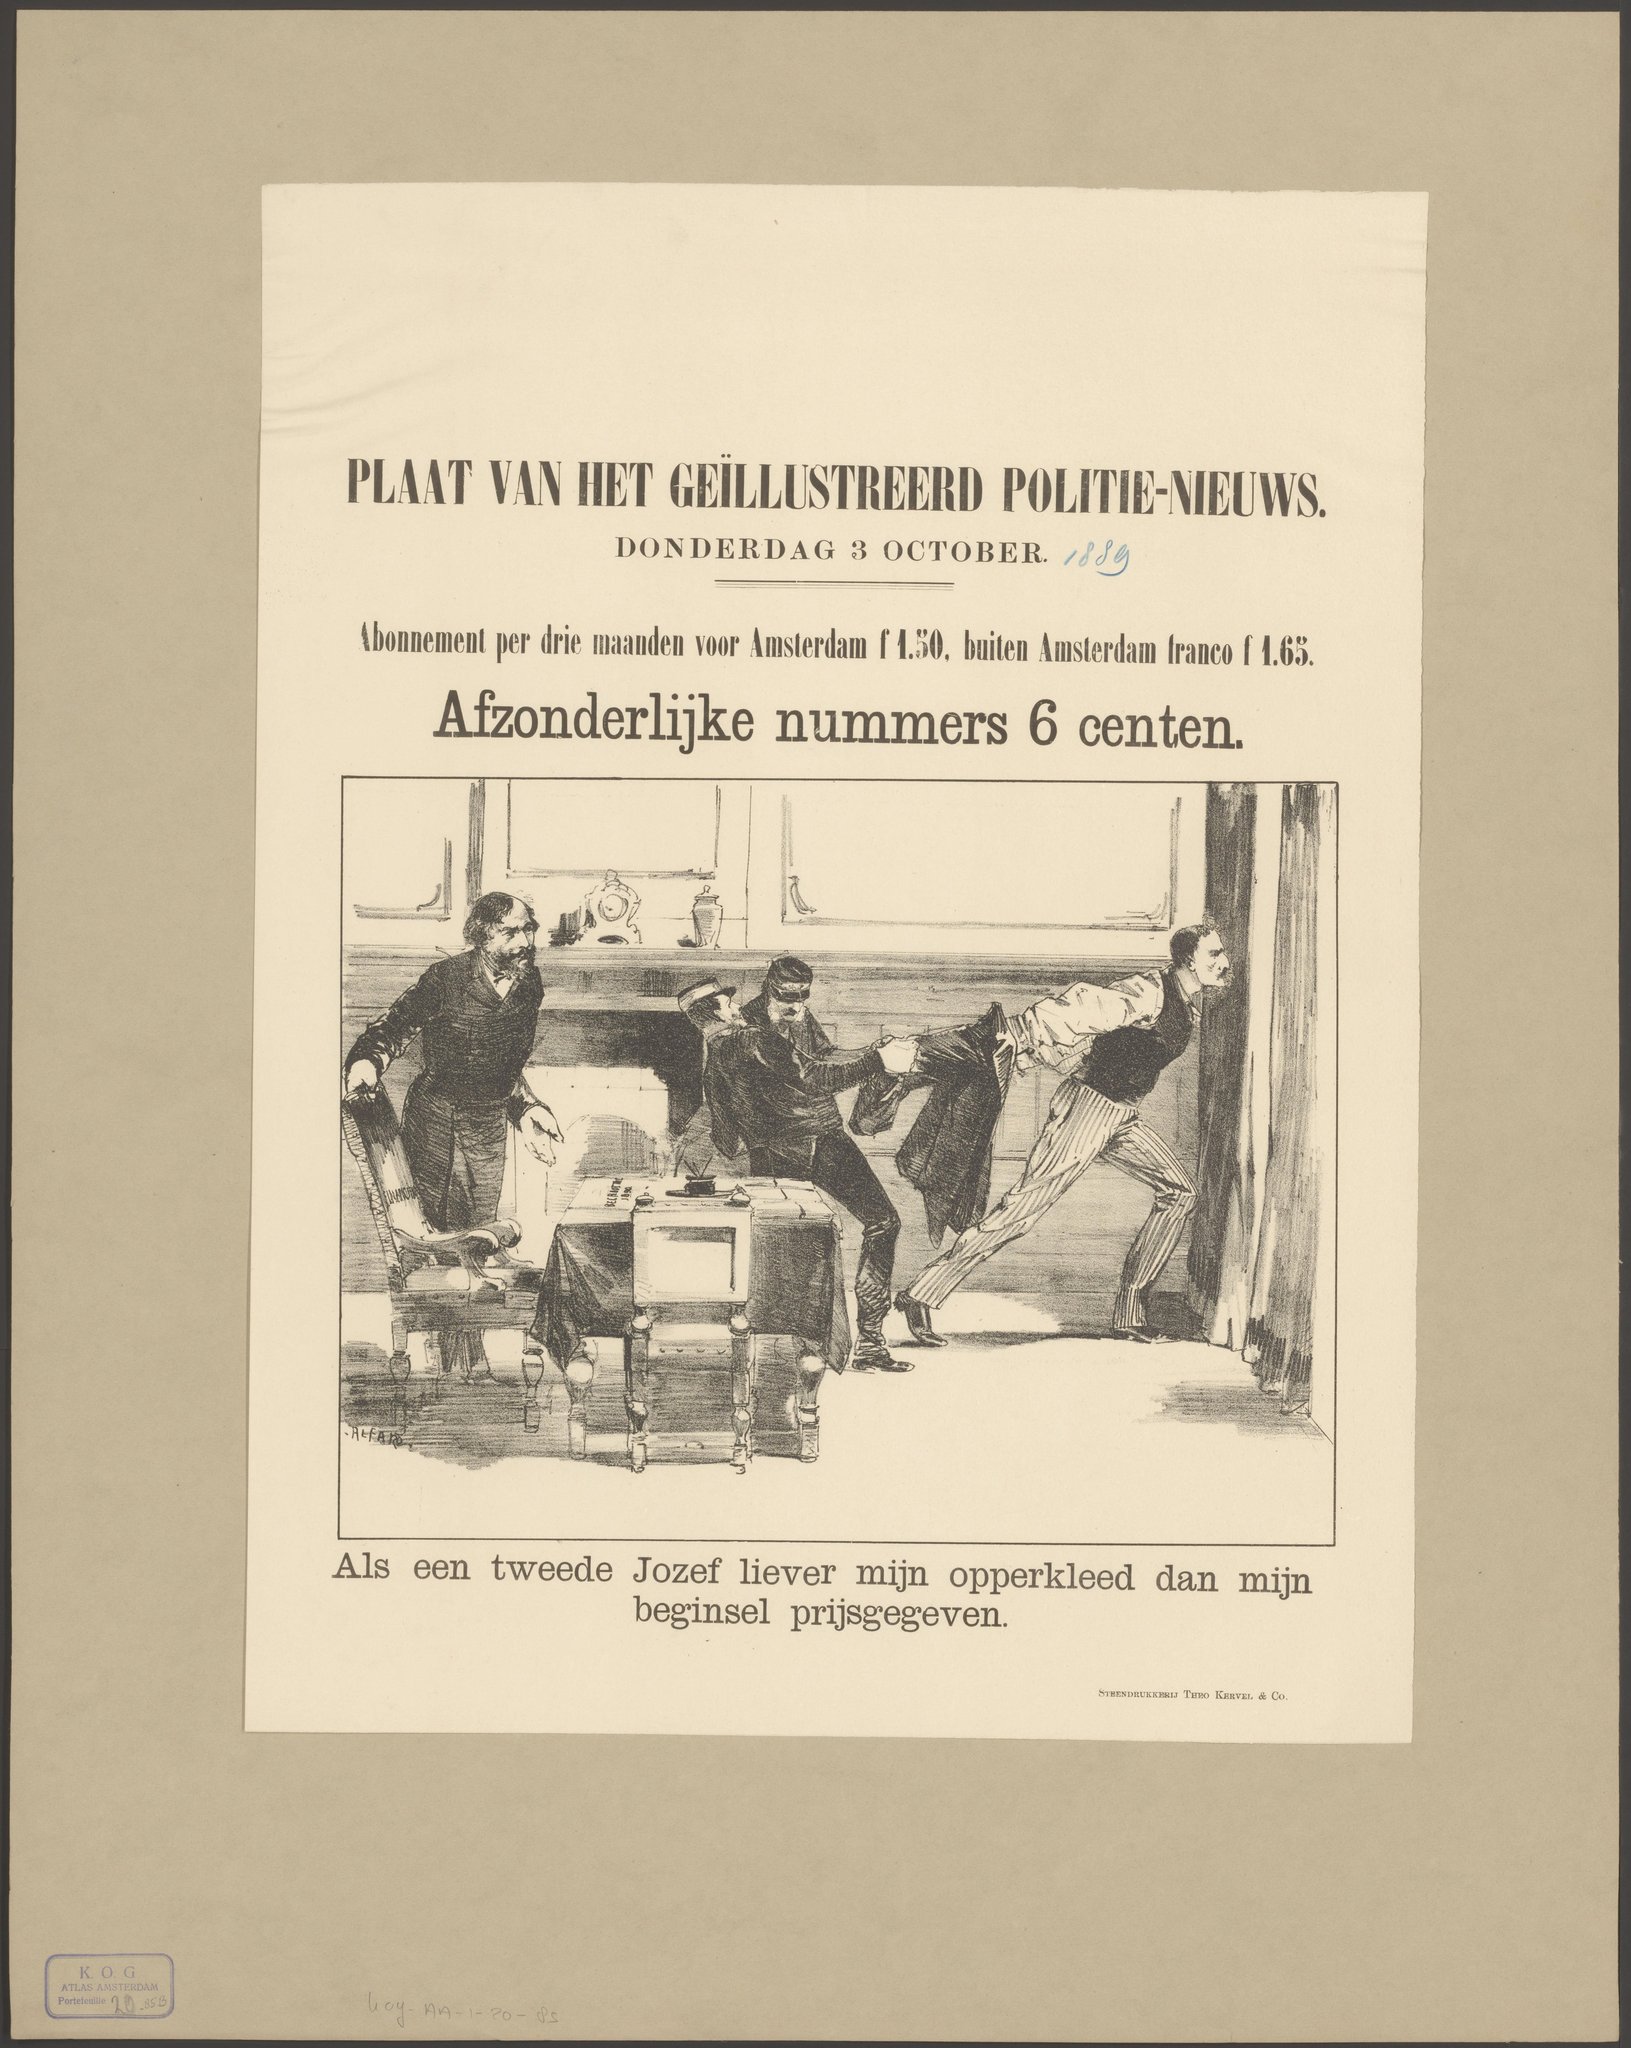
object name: cartoon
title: Als een tweede Jozef liever mijn opperkleed dan mijn beginsel prijsgeven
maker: alfaro reijding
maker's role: draughtsman, engineer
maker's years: 1863-1930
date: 1889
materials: paper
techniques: letterpress printing, lithograph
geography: amsterdam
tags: mayor, gijsbert van tienhoven, politician, e.g. party leader, political caricatures and satires, amsterdam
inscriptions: collector's mark: Lugt 1641b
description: Gepubliceerd als bijvoegsel van 'Geïllustreerd Politie-Nieuws', 3 oktober 1889.